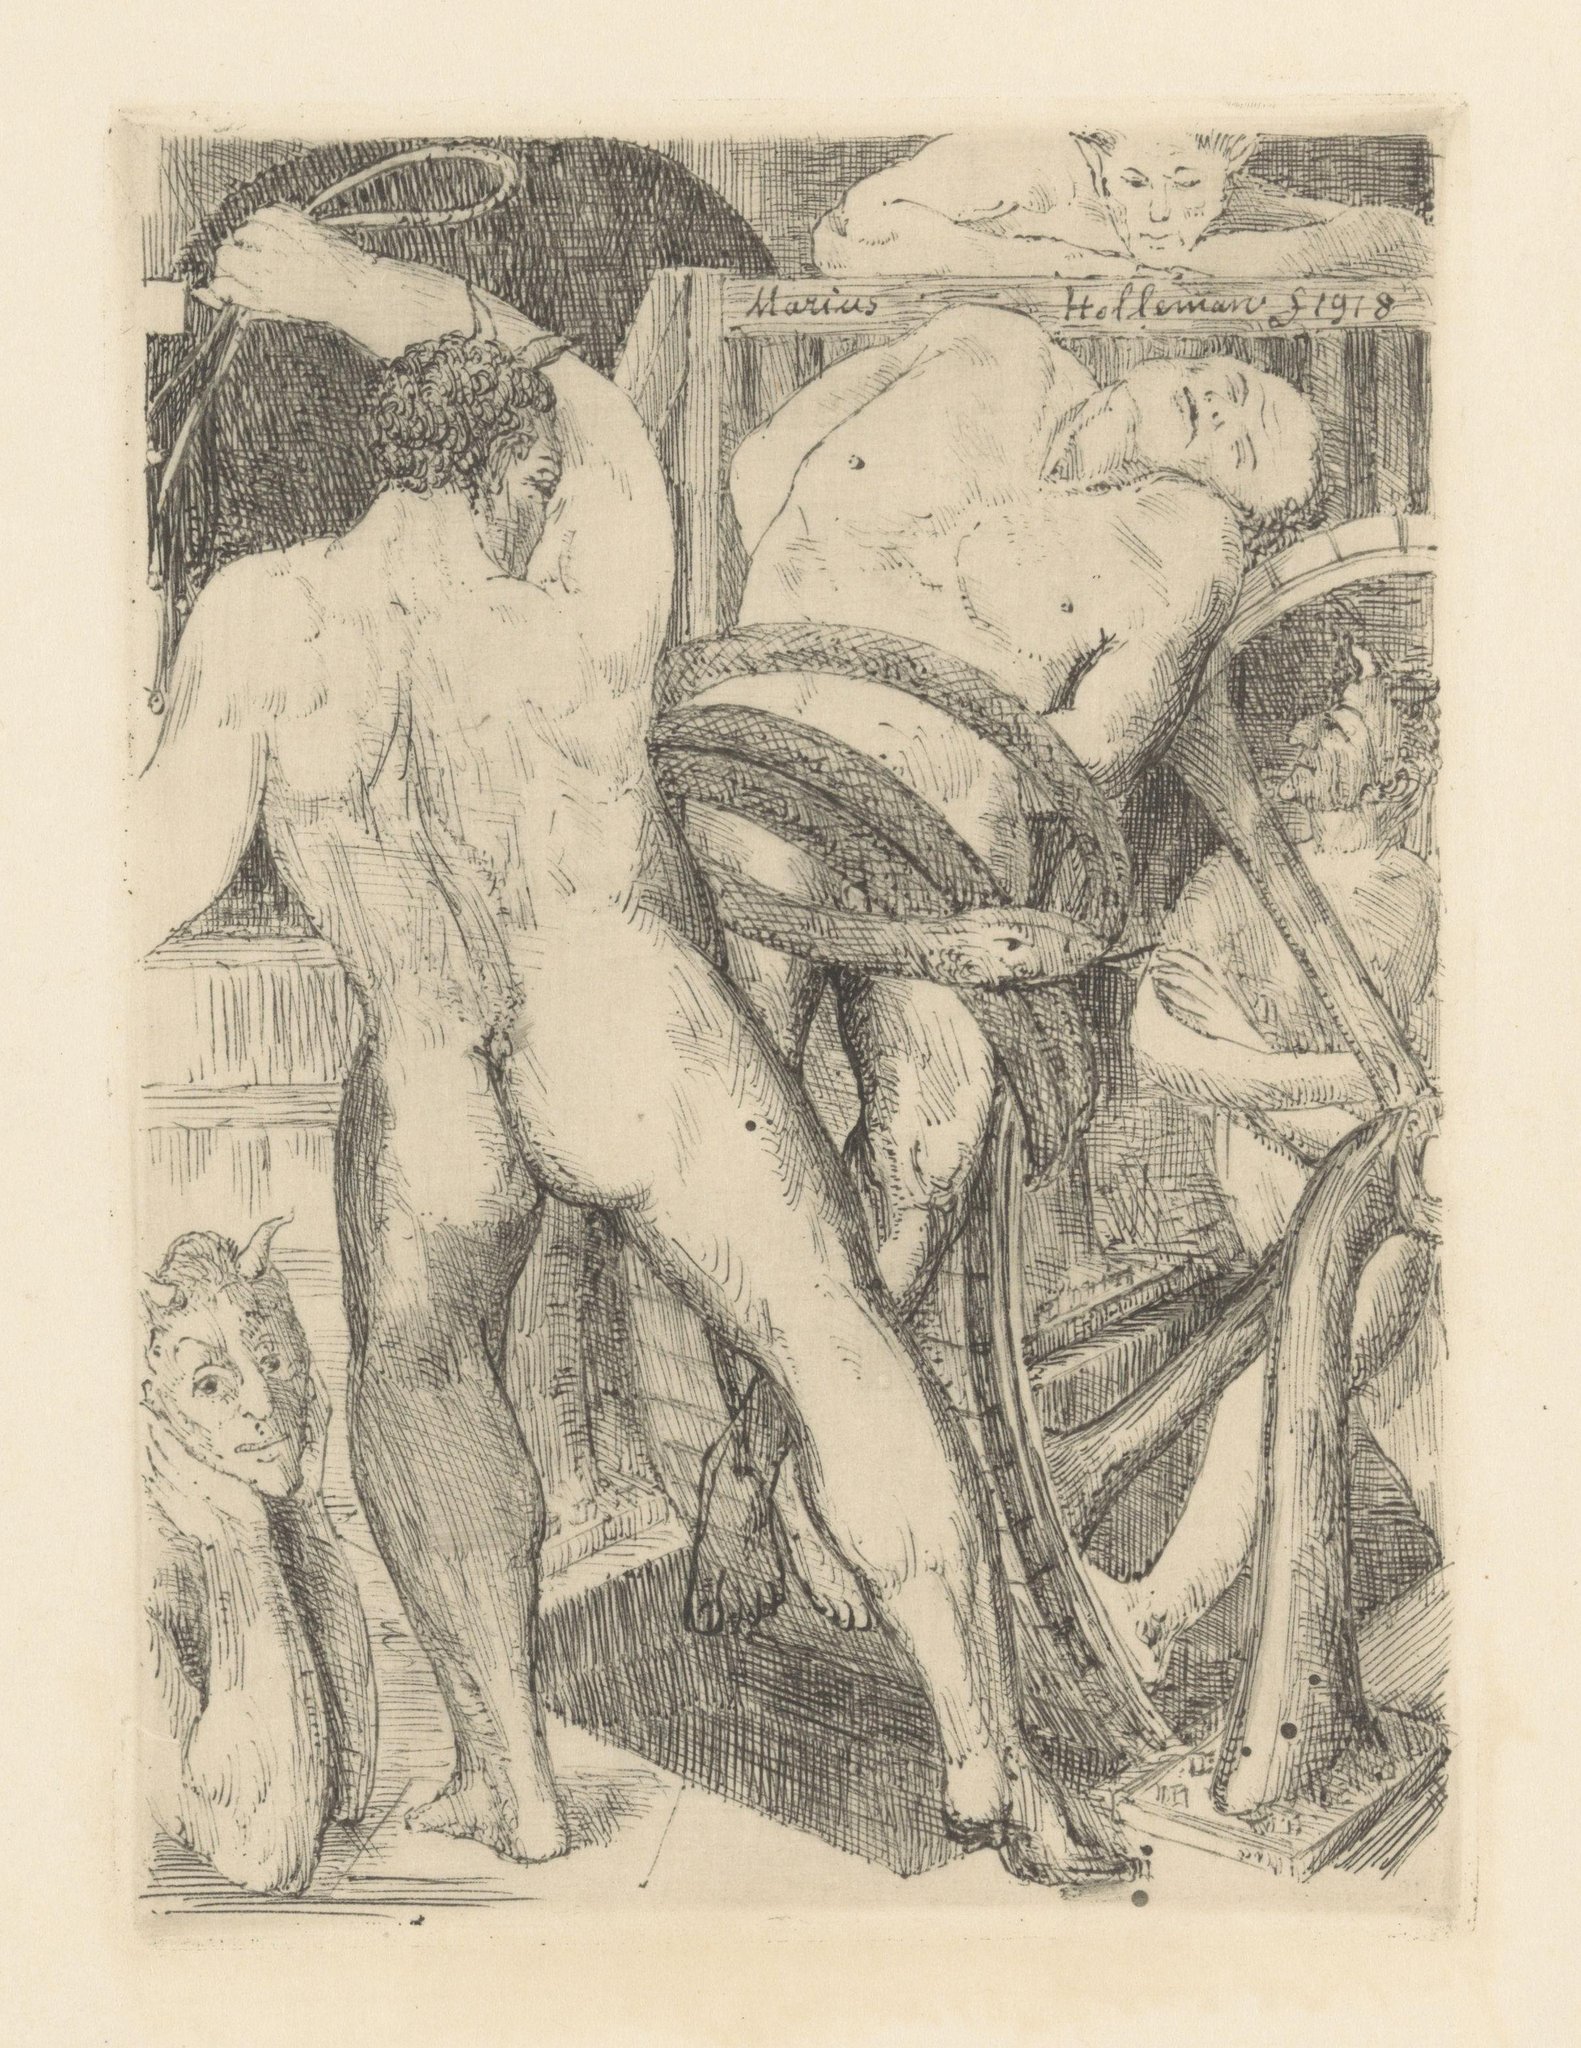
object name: print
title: Ixion in de Tartarus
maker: marius holleman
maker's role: draughtsman, print maker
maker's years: 1878-1926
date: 1918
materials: paper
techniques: etching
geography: groningen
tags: tartarus (and the condemned assigned there)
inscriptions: collector's mark: Lugt 2228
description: Ixion vastgebonden aan een rad door een slang. Voor hem staat een sater op het punt hem met een zweep te slaan.